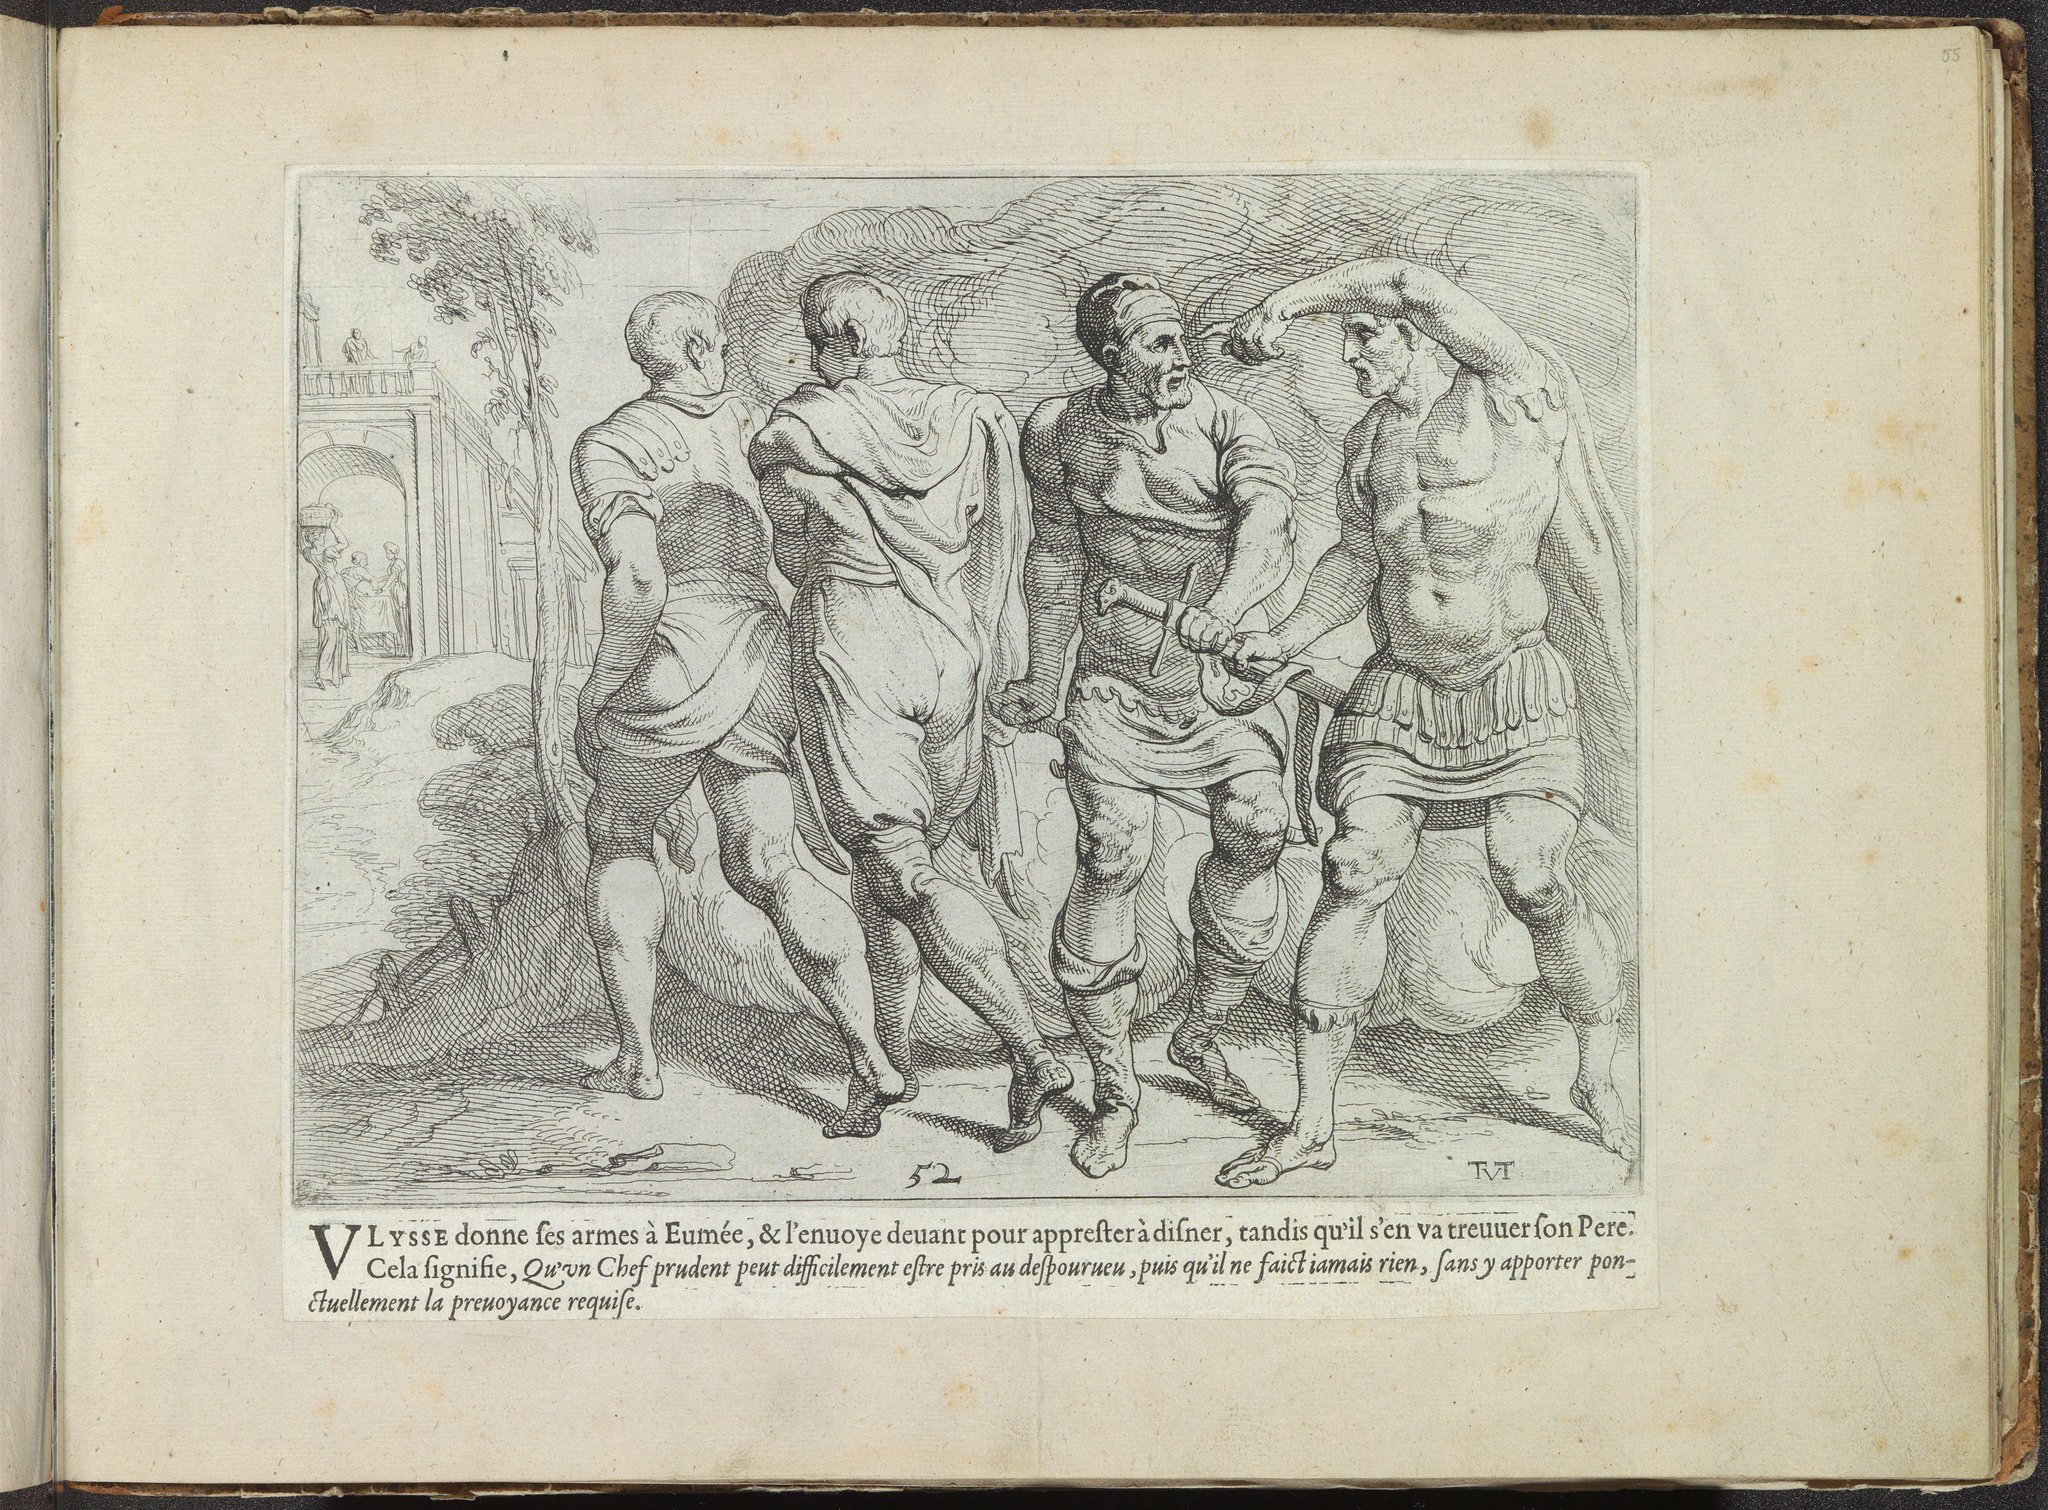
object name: print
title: De werken van Odysseus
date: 1633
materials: paper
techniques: engraving, etching, letterpress printing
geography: paris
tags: sequel to the death of the suitors (homer, odyssey xxiv)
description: Odysseus, zijn zoon Telemachus, Eumaeus en Philoetius arriveren verborgen onder een donkere wolk bij de woonplaats van Laërtes. Odysseus geeft zijn wapens aan Eumaeus. De prent maakt deel uit van een album.